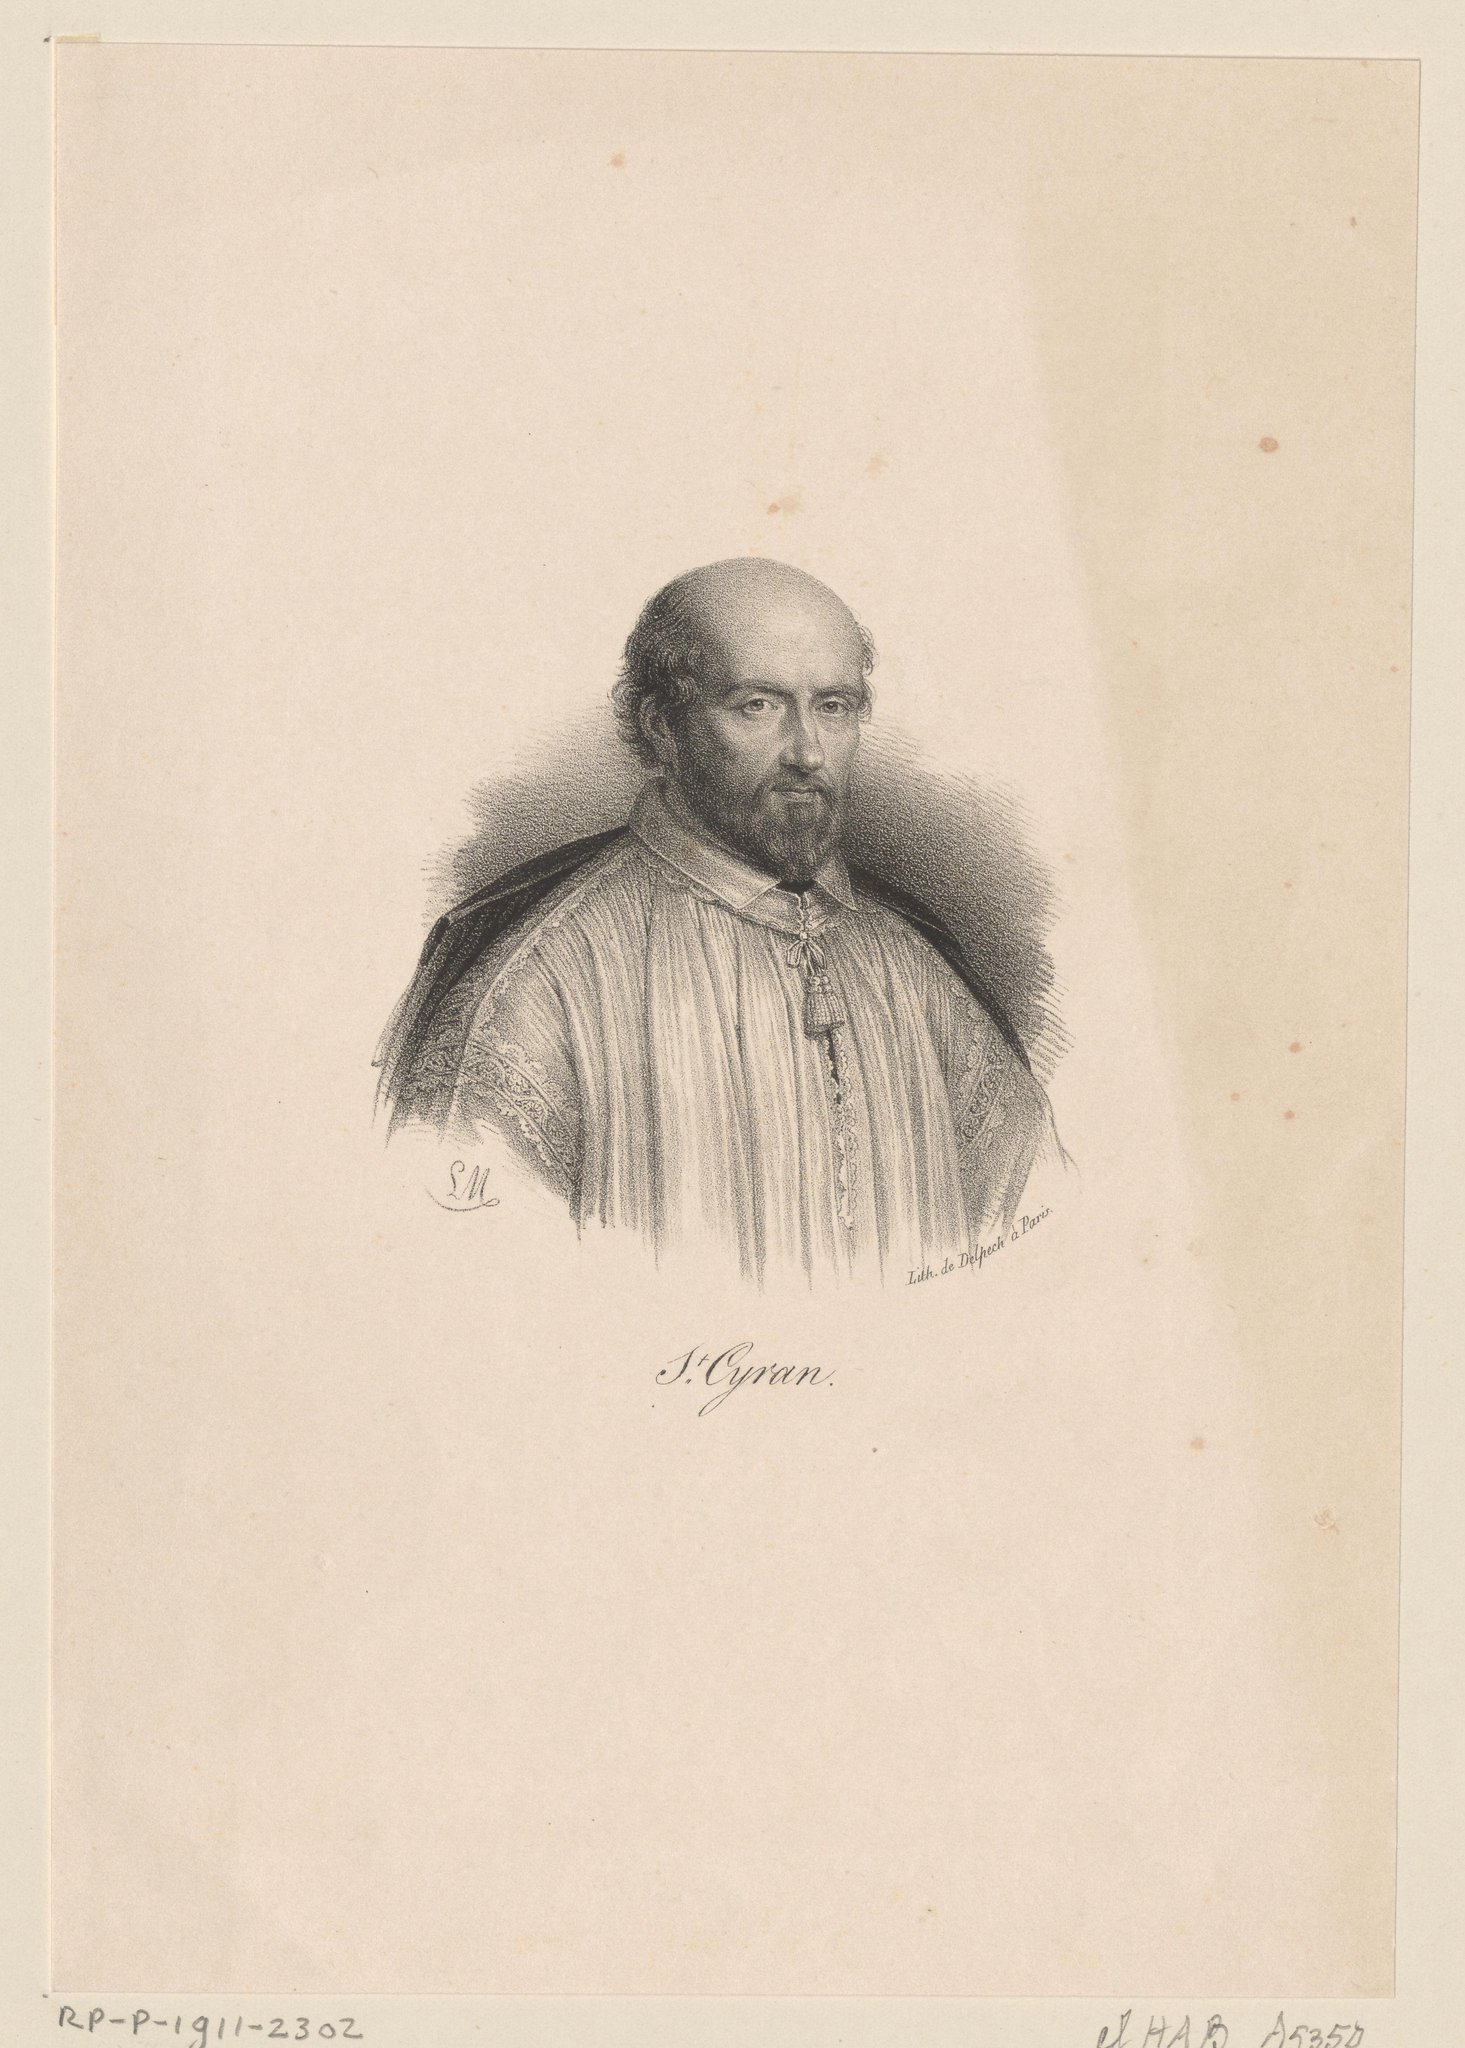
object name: print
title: Portret van Jean Duvergier de Hauranne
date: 1826-1842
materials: paper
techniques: lithograph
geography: paris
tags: paris, priest, abbot, historical persons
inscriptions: collector's mark: Lugt 2228